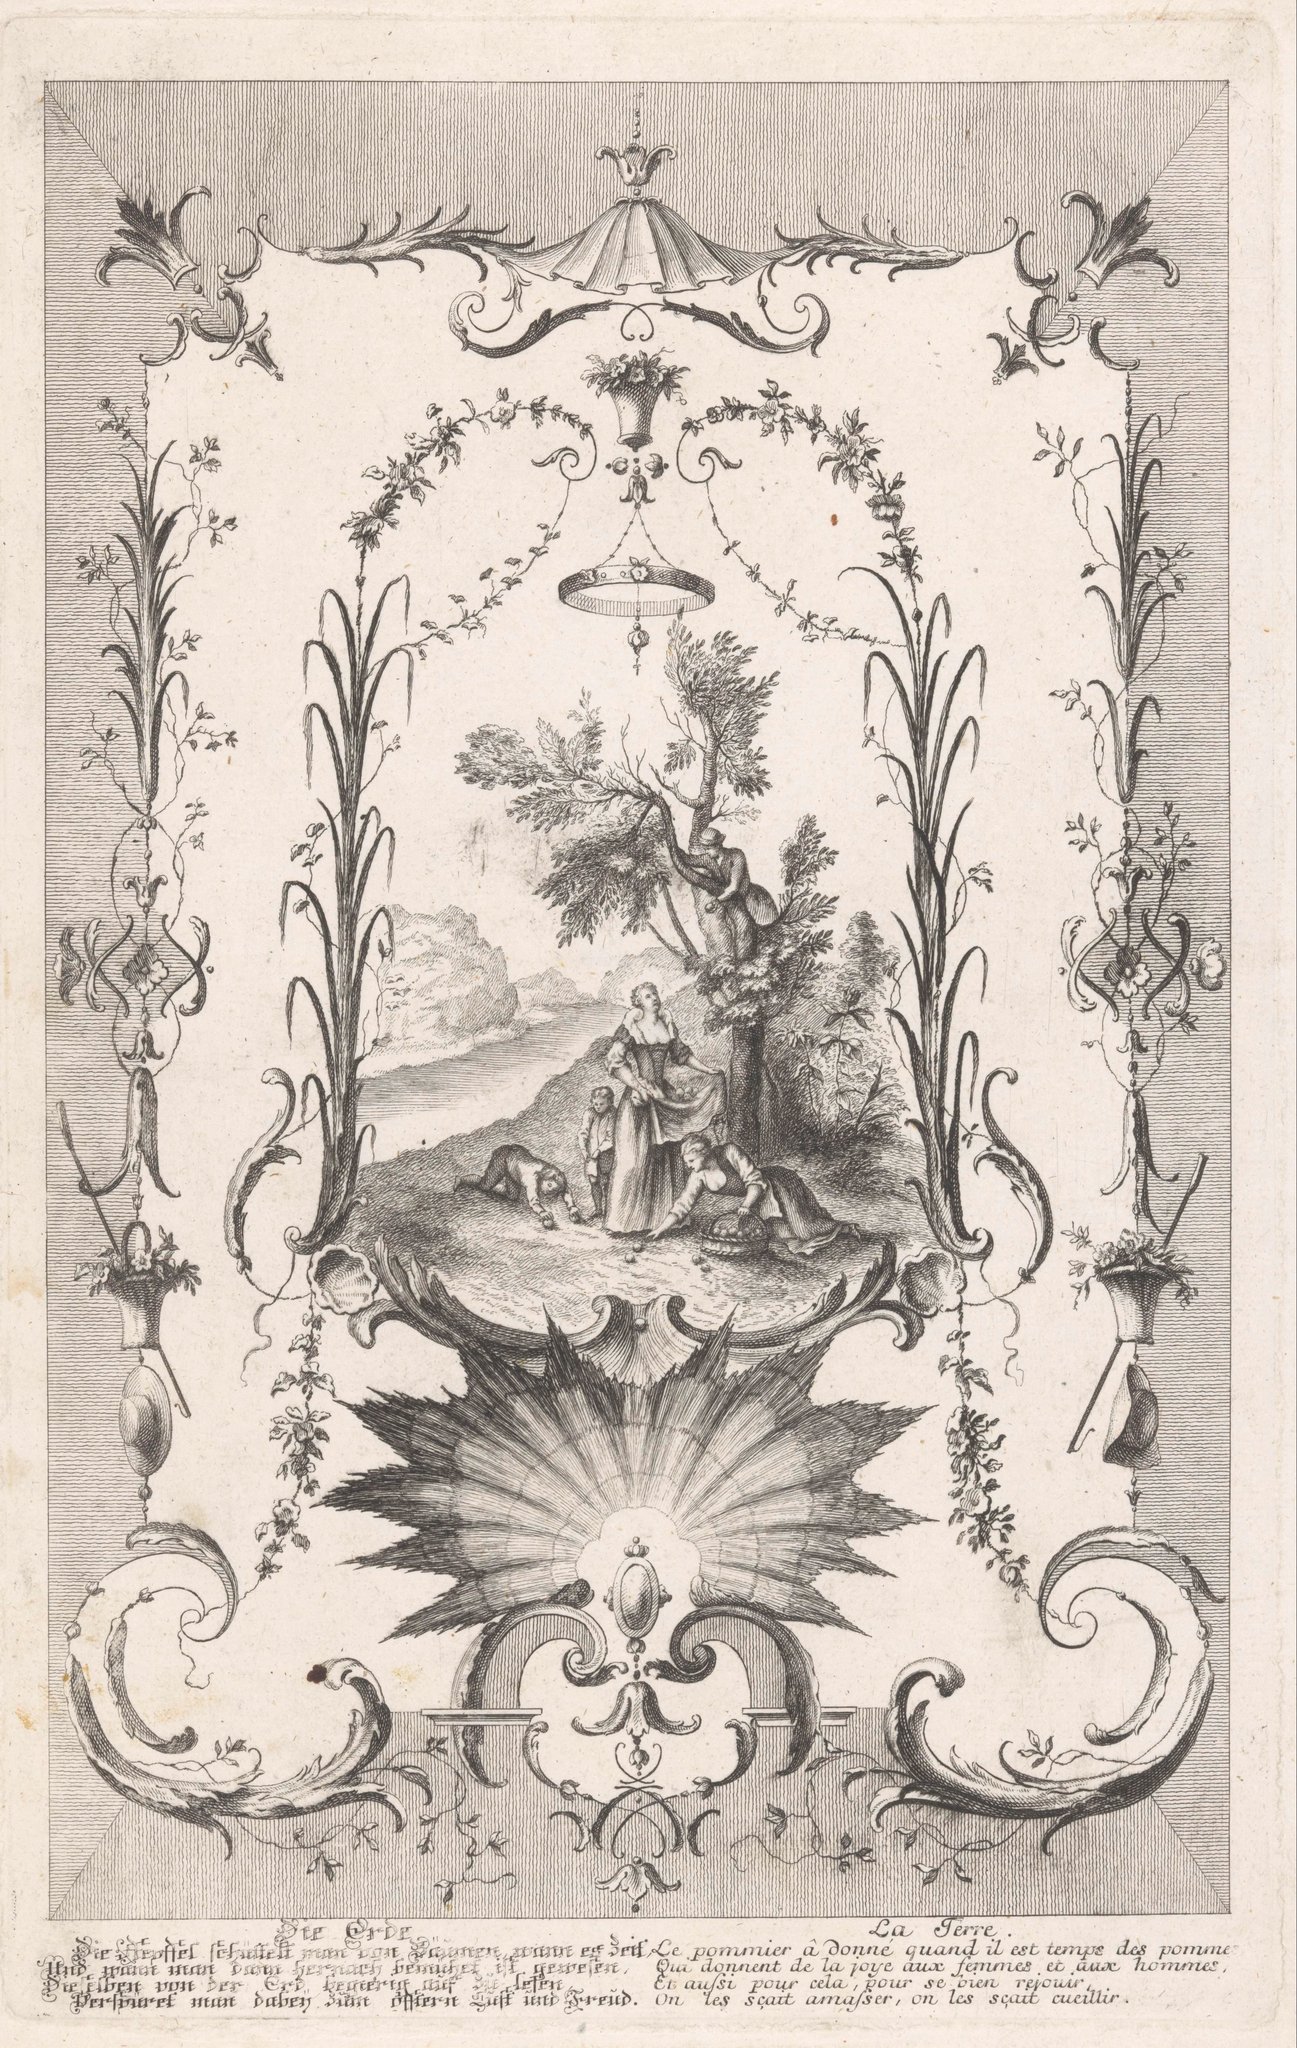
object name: print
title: Aarde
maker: Anonymous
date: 1729-1800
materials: paper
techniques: etching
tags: shaking down, tossing down the fruit, picking fruit, 'terra', 'carro della terra' (ripa)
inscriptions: collector's mark: Lugt 2228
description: Allegorie van het element aarde in een omlijsting van bloemen, manden en herdershoeden- en staffen. Een vrouw staat onder een fruitboom en vangt de vruchten die een man in de boom plukt. Op de grond verzamelen kinderen de gevallen vruchten. In de ondermarge tweemaal een vierregelige Duite en Franse tekst.